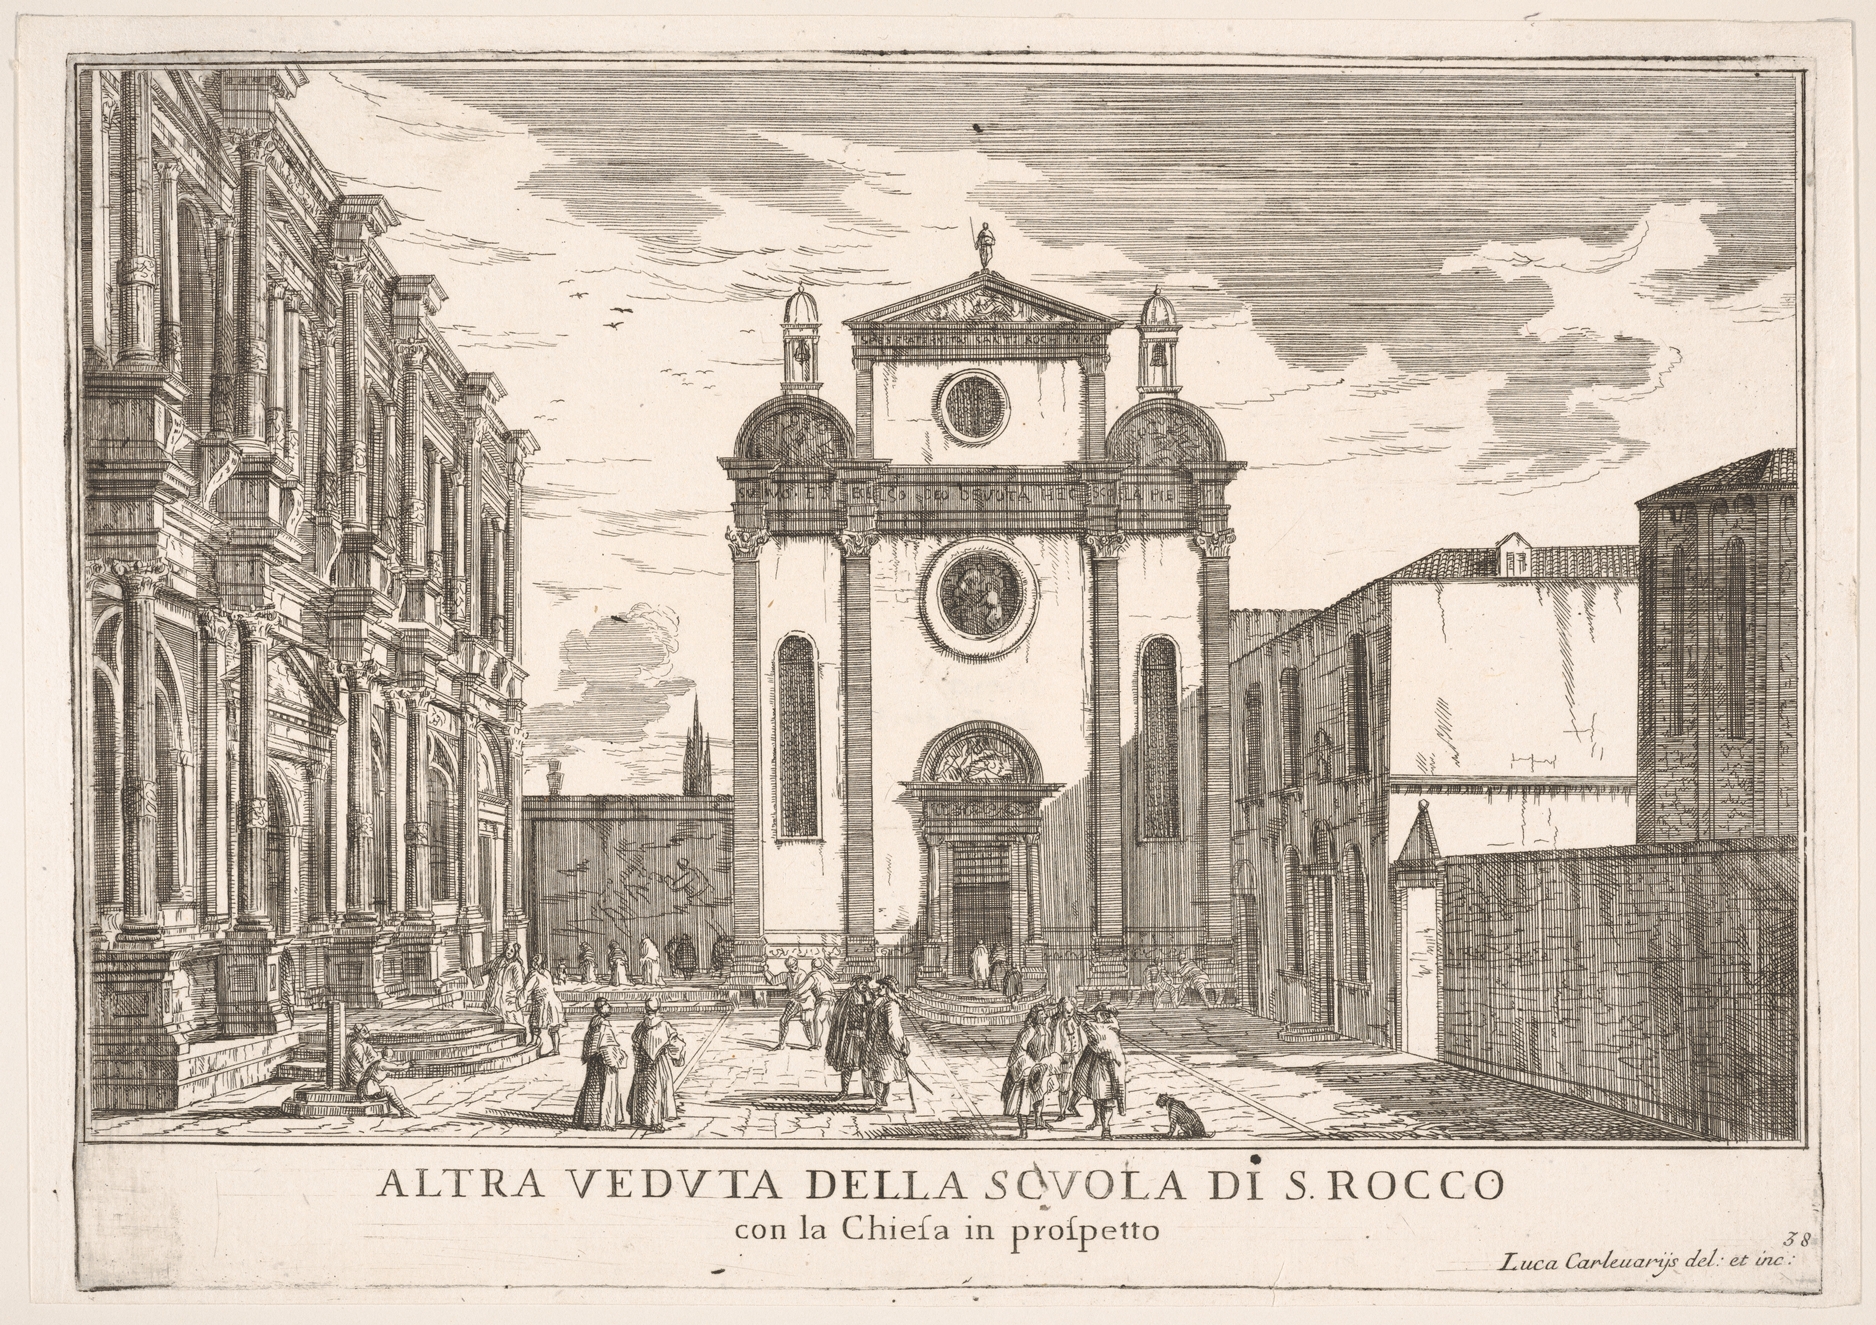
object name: print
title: Plate 38: View of the facade of the church of St. Roch and at left the facade of the School of St. Roch, Venice, 1703, from "The buildings and views of Venice" (Le fabriche e vedute di Venezia)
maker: luca carlevaris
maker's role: artist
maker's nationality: italian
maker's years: 1663-1730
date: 1703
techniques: etching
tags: architecture,churches,venice